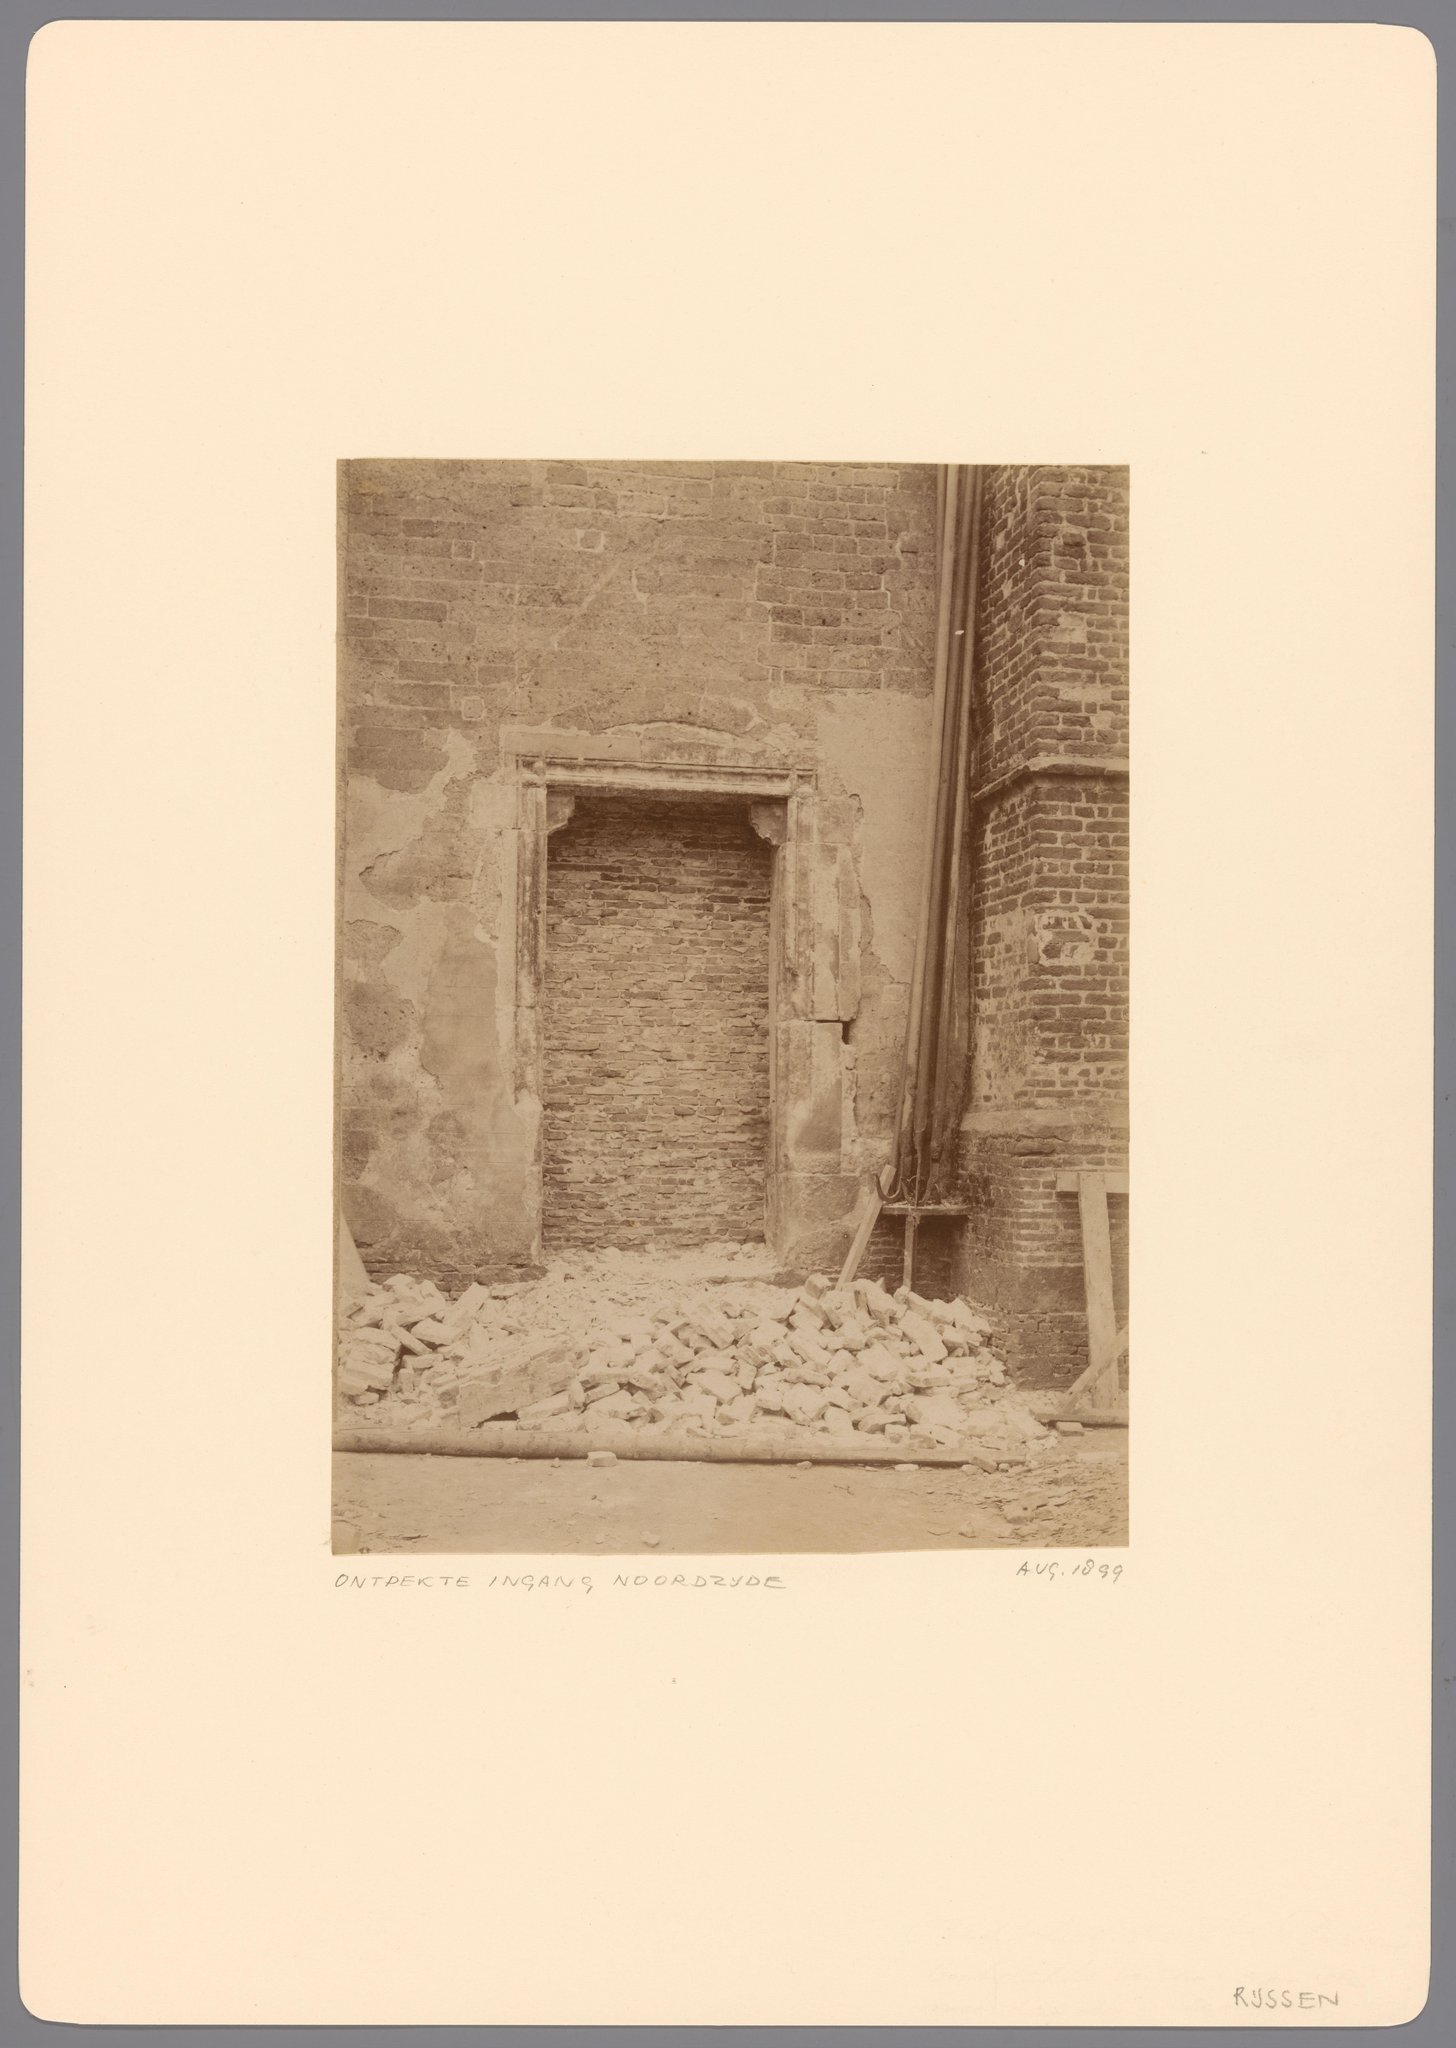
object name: photograph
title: Ontdekte ingang aan de noordzijde van de Grote of Schildkerk te Rijssen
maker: anoniem (monumentenzorg)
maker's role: fotograaf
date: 1899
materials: cardboard, photographic support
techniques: albumen print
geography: rijssen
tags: church (exterior), gate, entrance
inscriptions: annotation: ‘Rijssen- Ned. Herv. Kerk/ ontdekte ingang aan de noordzijde aug 1899’, annotation: ‘Ontdekte ingang noordzijde/ aug 1899/ Rijssen’